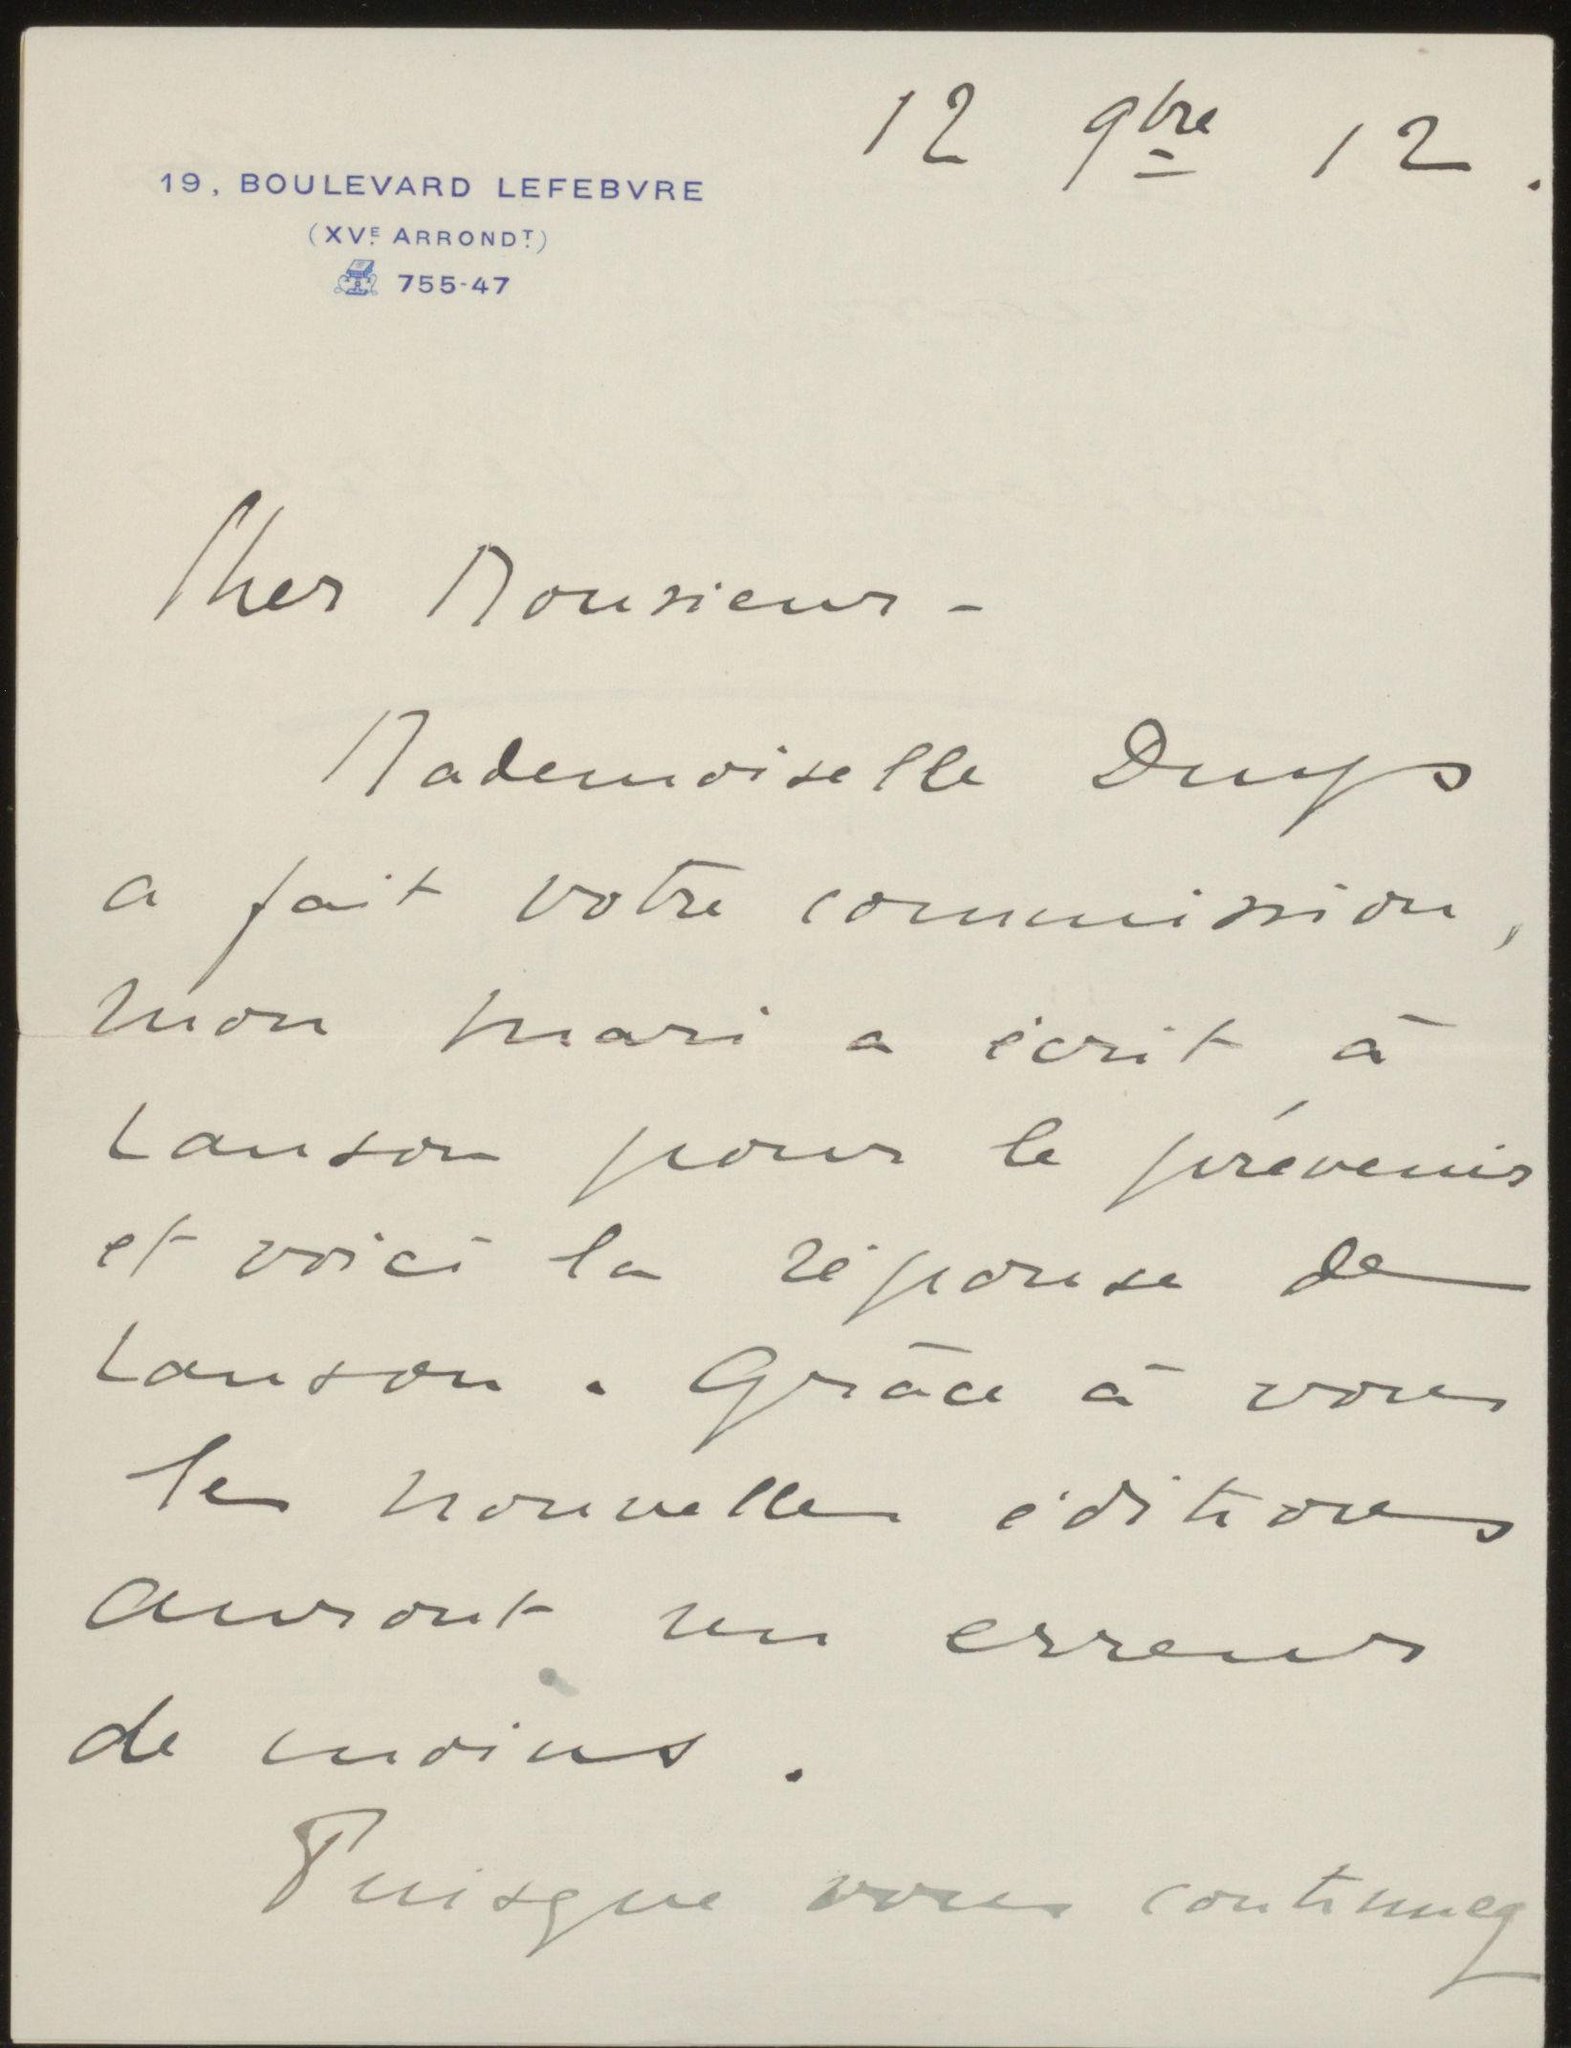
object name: letter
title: Brief aan Andries Bonger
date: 1912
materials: ink, paper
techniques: pen, printing, writing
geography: paris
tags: amsterdam, multatuli, andries bonger, paris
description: Brief bevat een copie van een brief van Gustave Lanson.